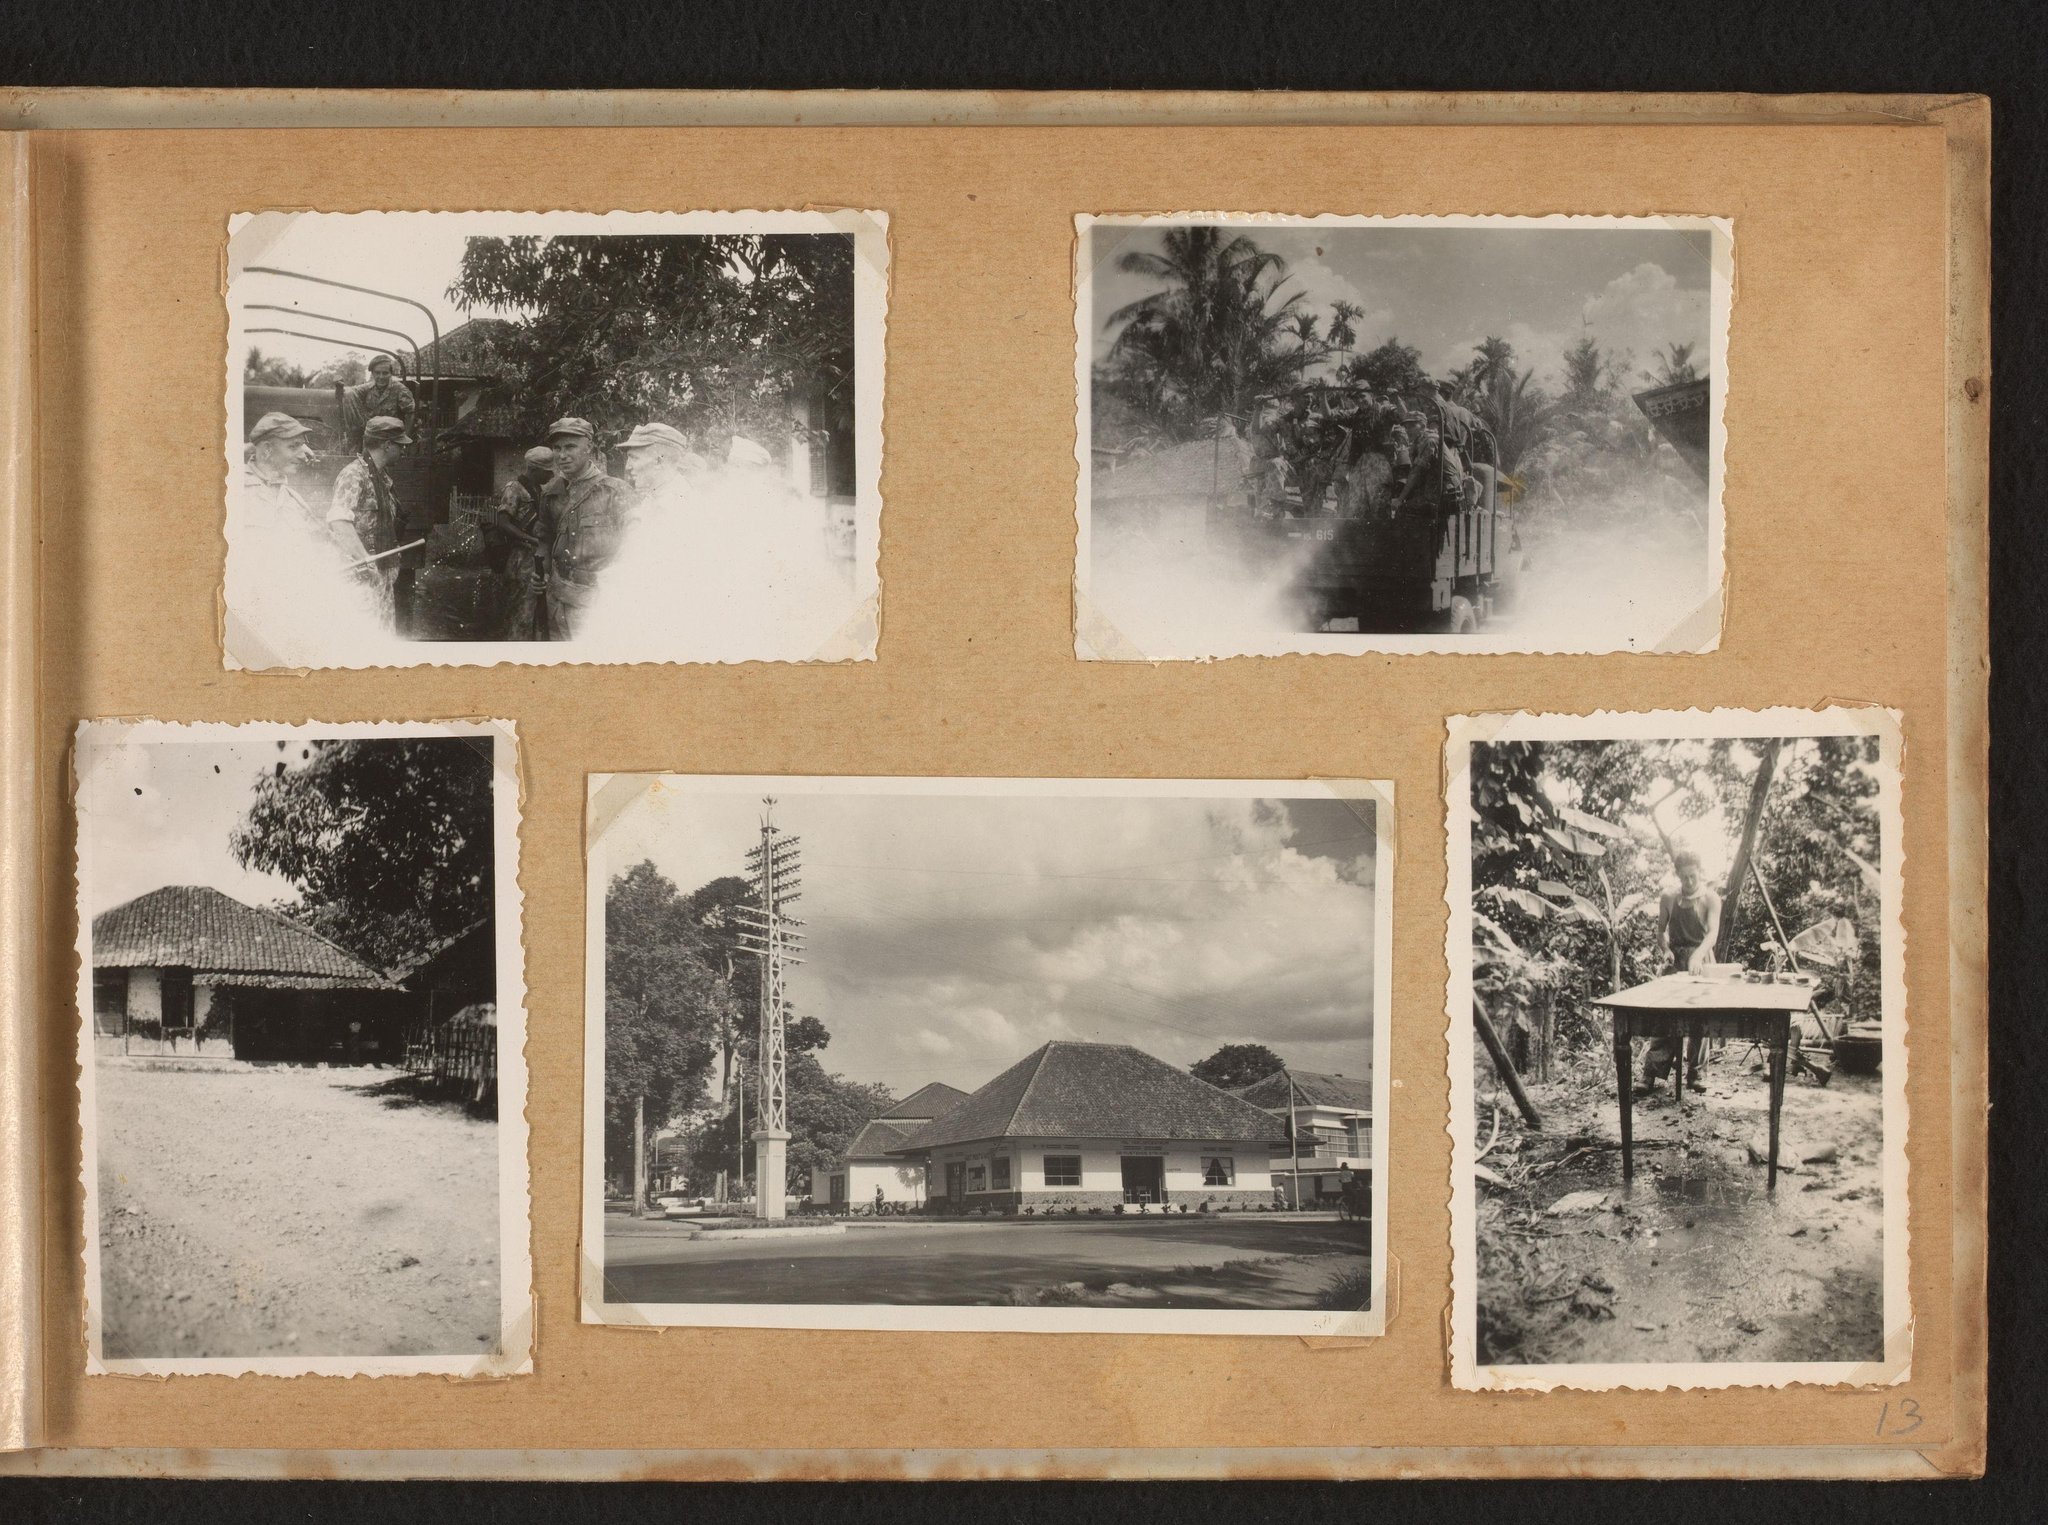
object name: album leaf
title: Transport in vrachtwagen en verlofcentrum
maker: Anonymous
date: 1948-1949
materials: paper, photographic support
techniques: gelatin silver print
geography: dutch east indies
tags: the company, the unit, the troop ~ military service, modern forms of military vehicles, recreation ~ the soldier off duty, transport, train (military), dutch east indies, the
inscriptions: inscription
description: Albumblad met vijf foto's van een transport van Nederlandse militairen in een vrachtwagen en van het Militair Verlofcentrum 'De Rustende Strijder' in Bandoeng. Onderdeel van het fotoalbum 'Ter herinnering aan mijn diensttijd overzee' 1948-1949.